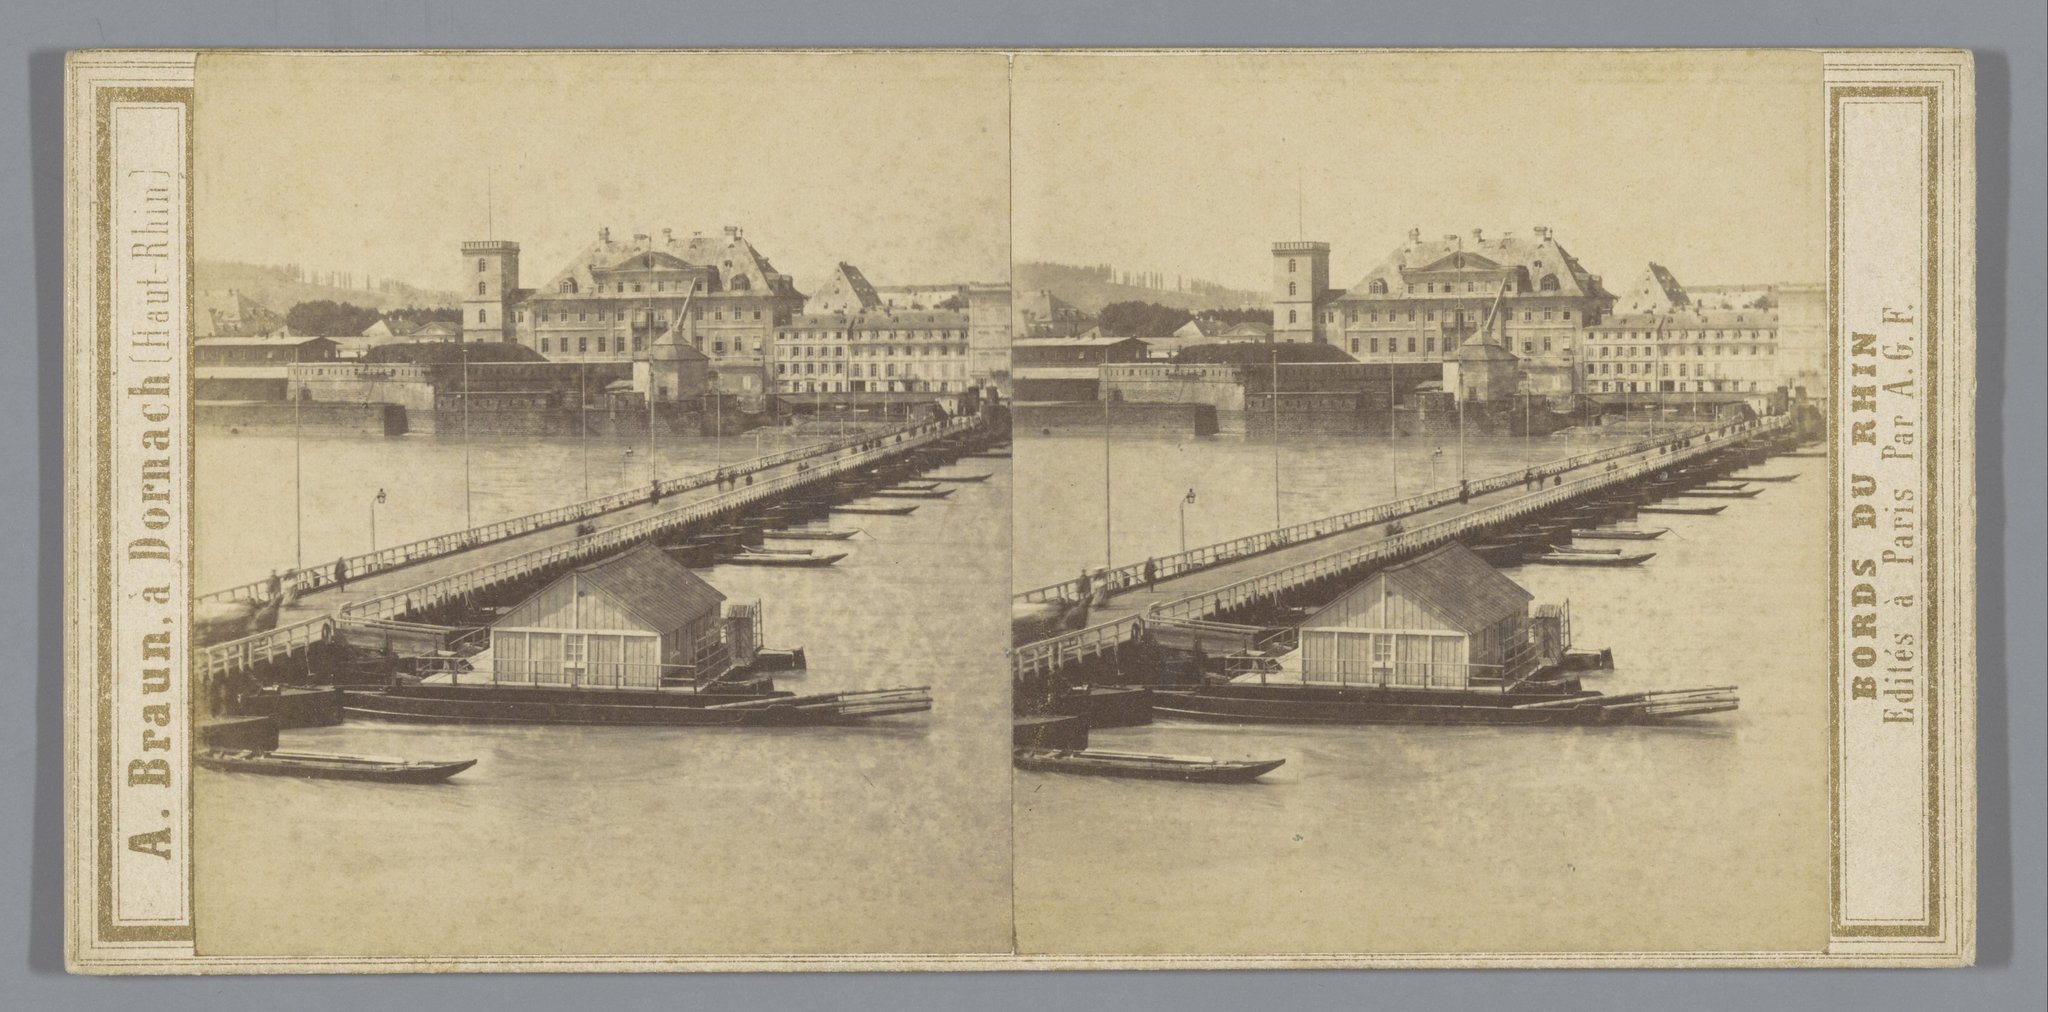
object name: stereograph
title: Gezicht op de Schiffbrücke in Koblenz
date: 1860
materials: cardboard, paper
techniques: albumen print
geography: paris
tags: bridge in city across river, canal, etc.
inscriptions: number: ‘878.’, inscription: ‘1875 No 25 Za. 25 Sept./ Juli 1881./ Aug 1885.’, number: ‘5.’